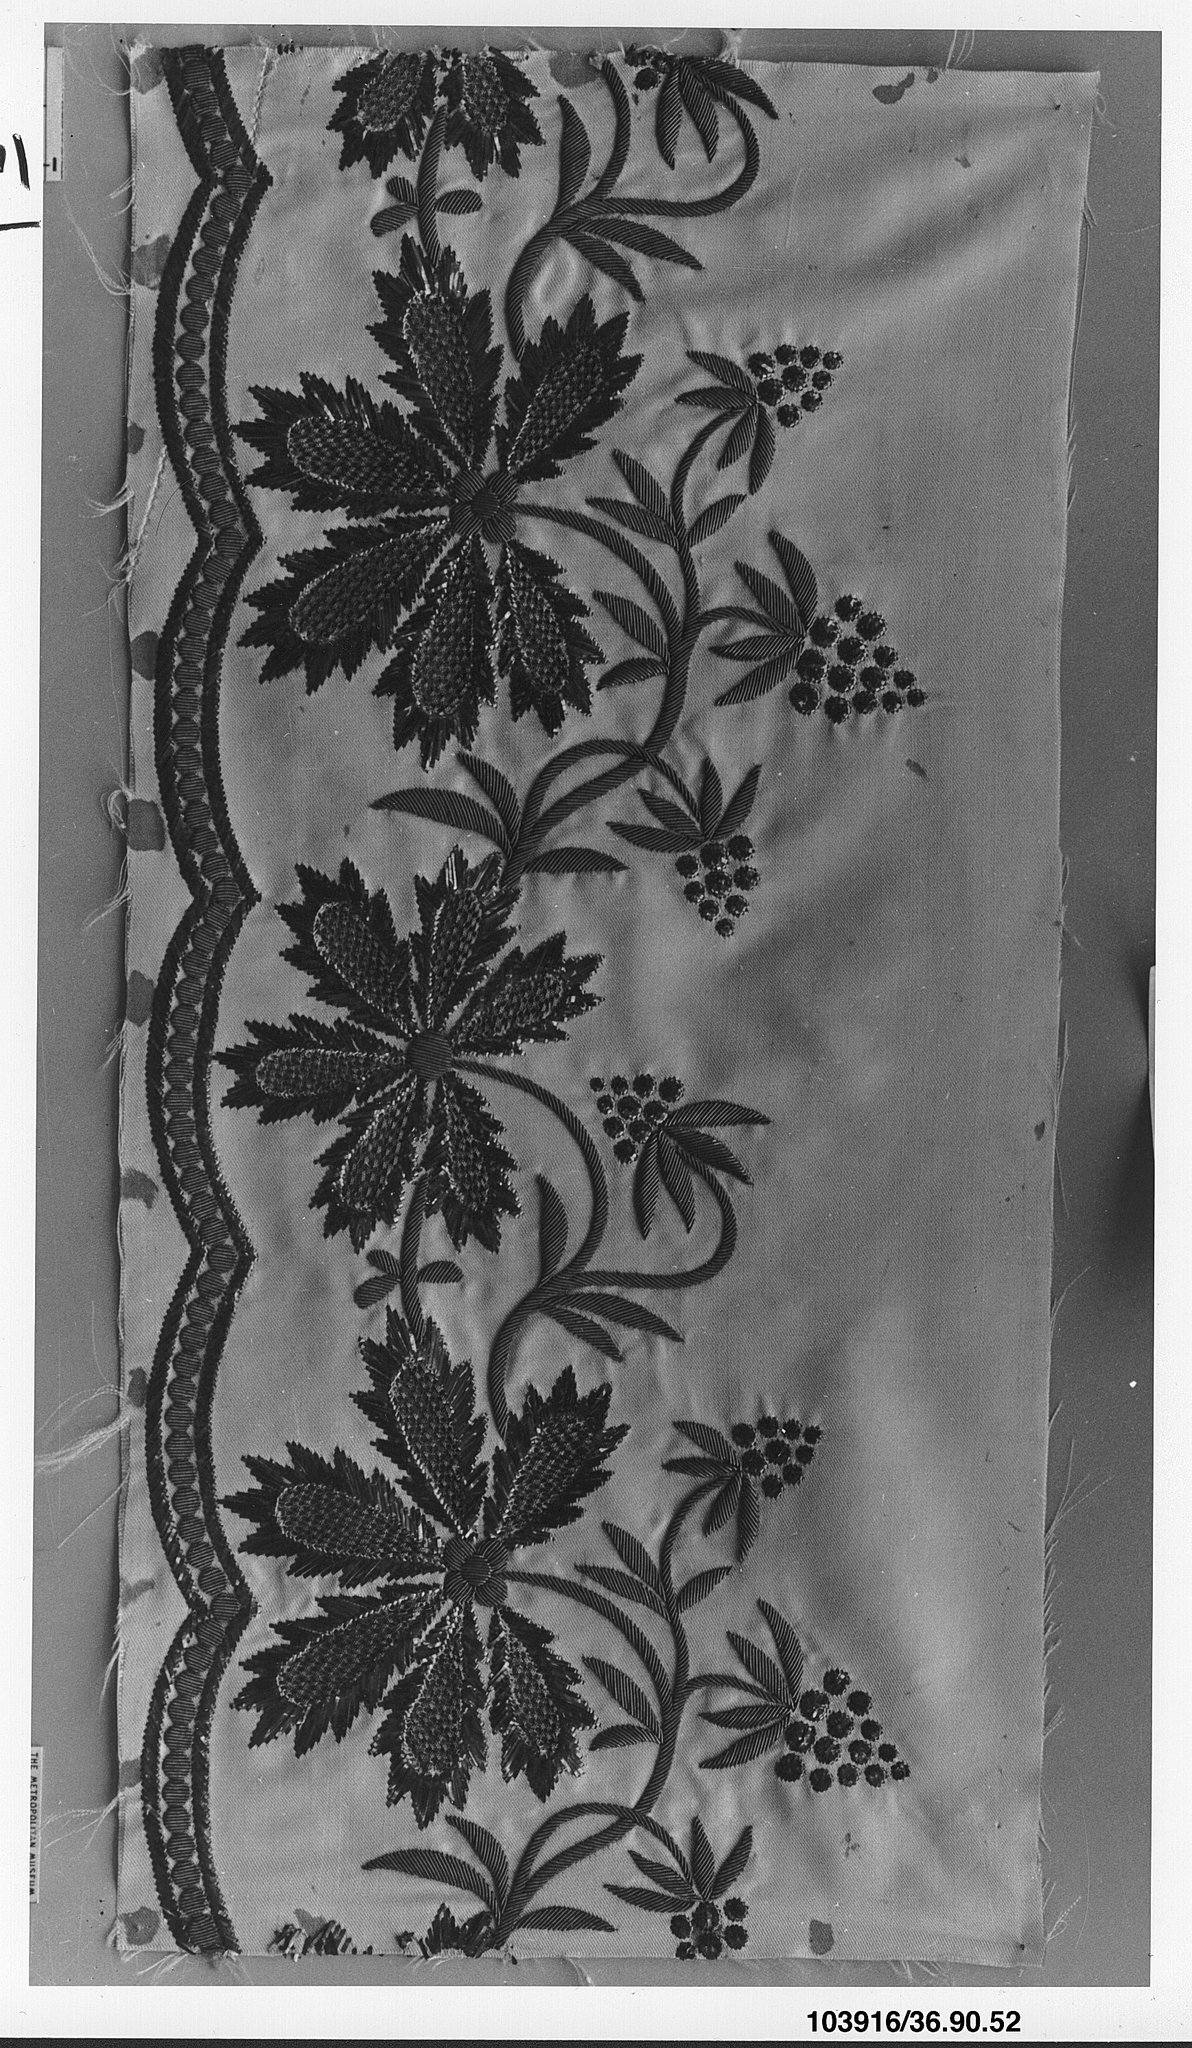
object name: border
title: Dress border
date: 1801-1833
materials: metal thread, silk